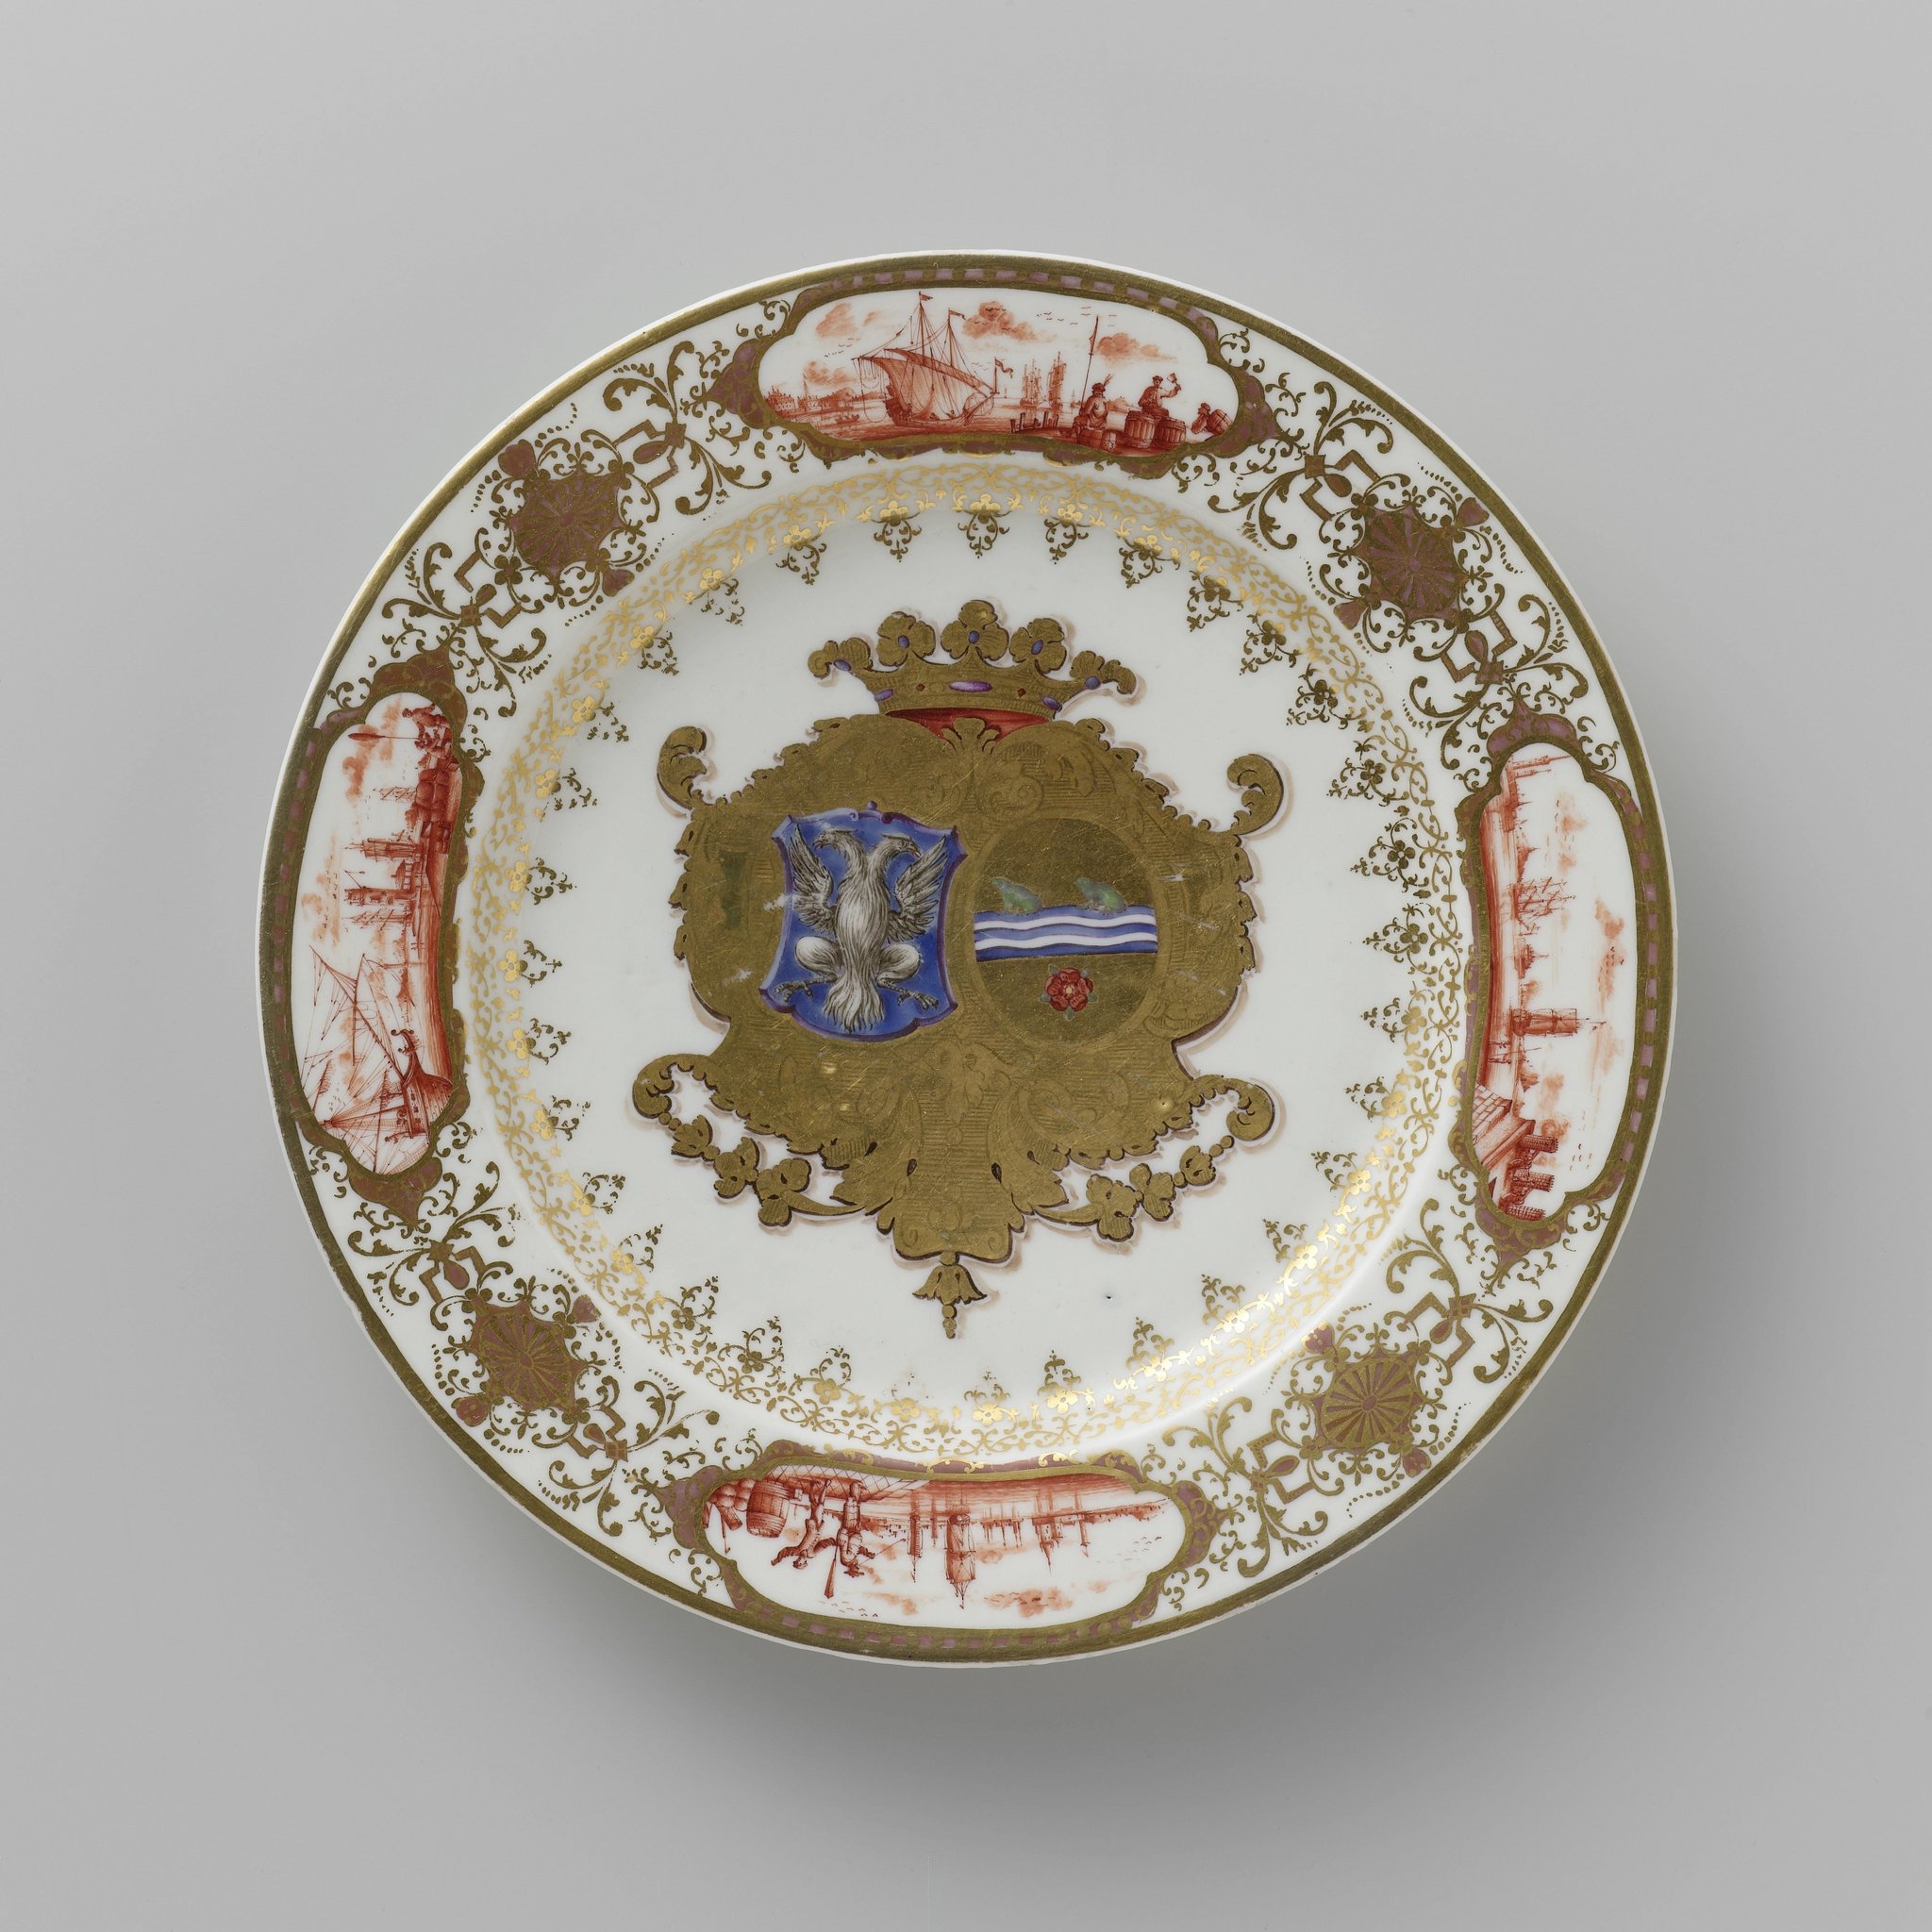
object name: plate dish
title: Plate with the Hasselaer–Kick alliance arms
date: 1726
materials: porcelain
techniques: painted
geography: meissen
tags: amsterdam, politician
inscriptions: factory mark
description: This plate was probably made for the marriage of Nicolaas, Cornelis Hasselaer and Anna Divera Kick Pancras in, Amsterdam, in 1726., Porcelain plates with family coats of arms were fairly, common in the Netherlands and had initially been ordered, from Asia. However, in the early 18th century European, porcelain was the new rage, and the armorial plate was, ordered in Meissen rather than China.